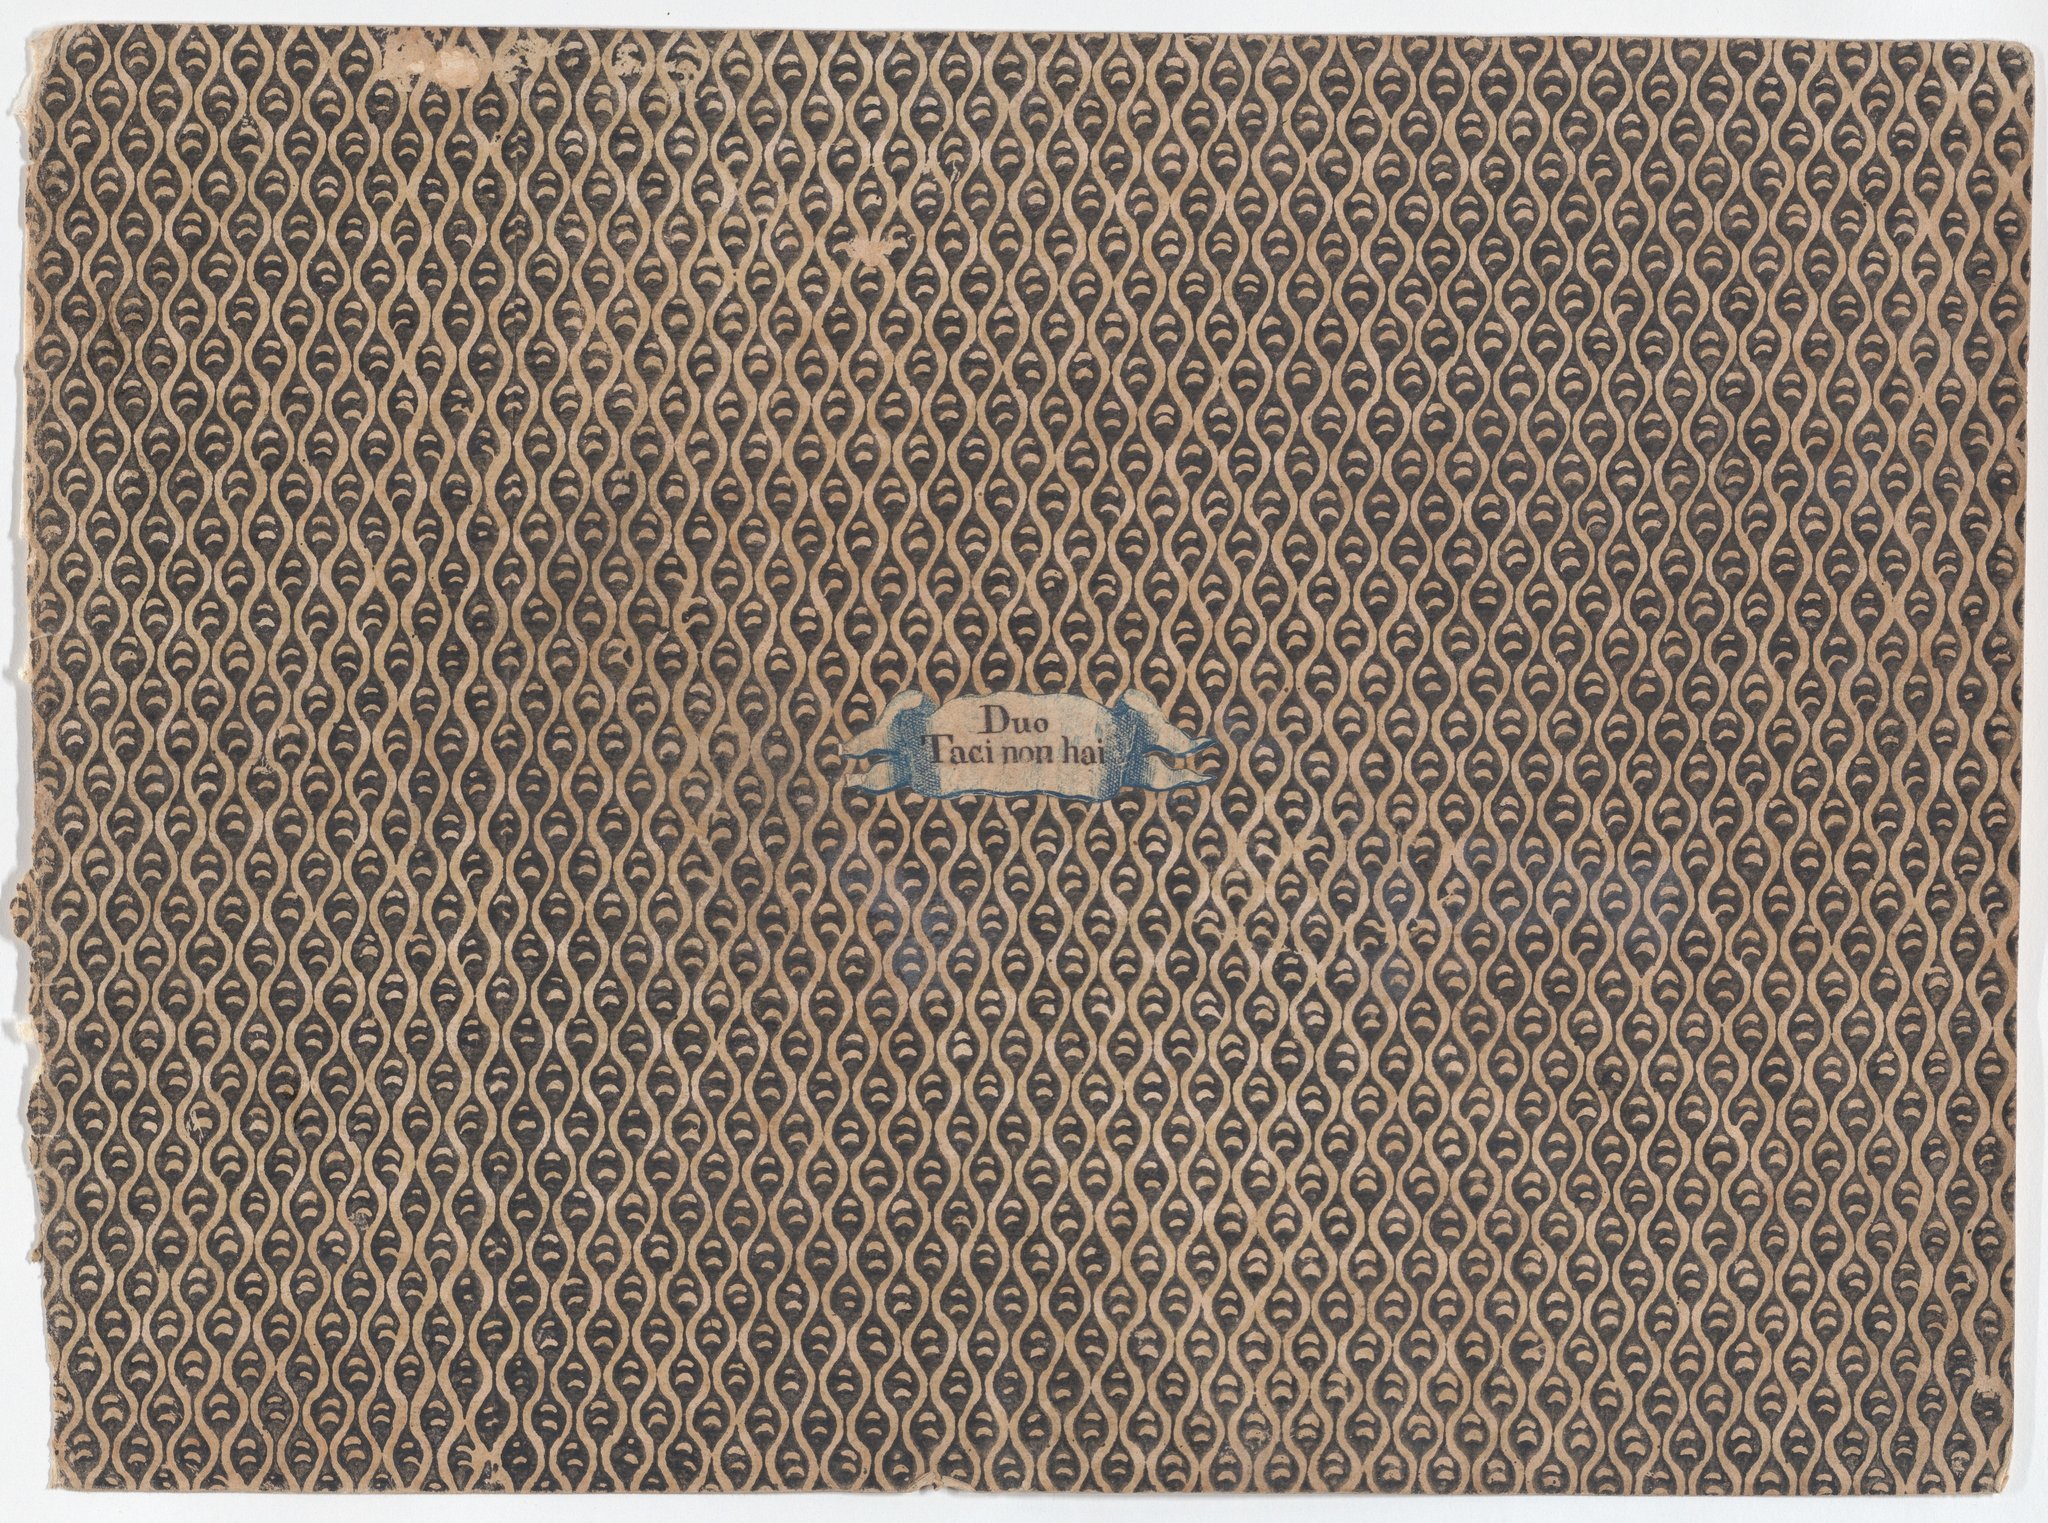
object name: print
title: Sheet with overall abstract pattern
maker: Anonymous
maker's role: artist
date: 1801-1900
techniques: relief print